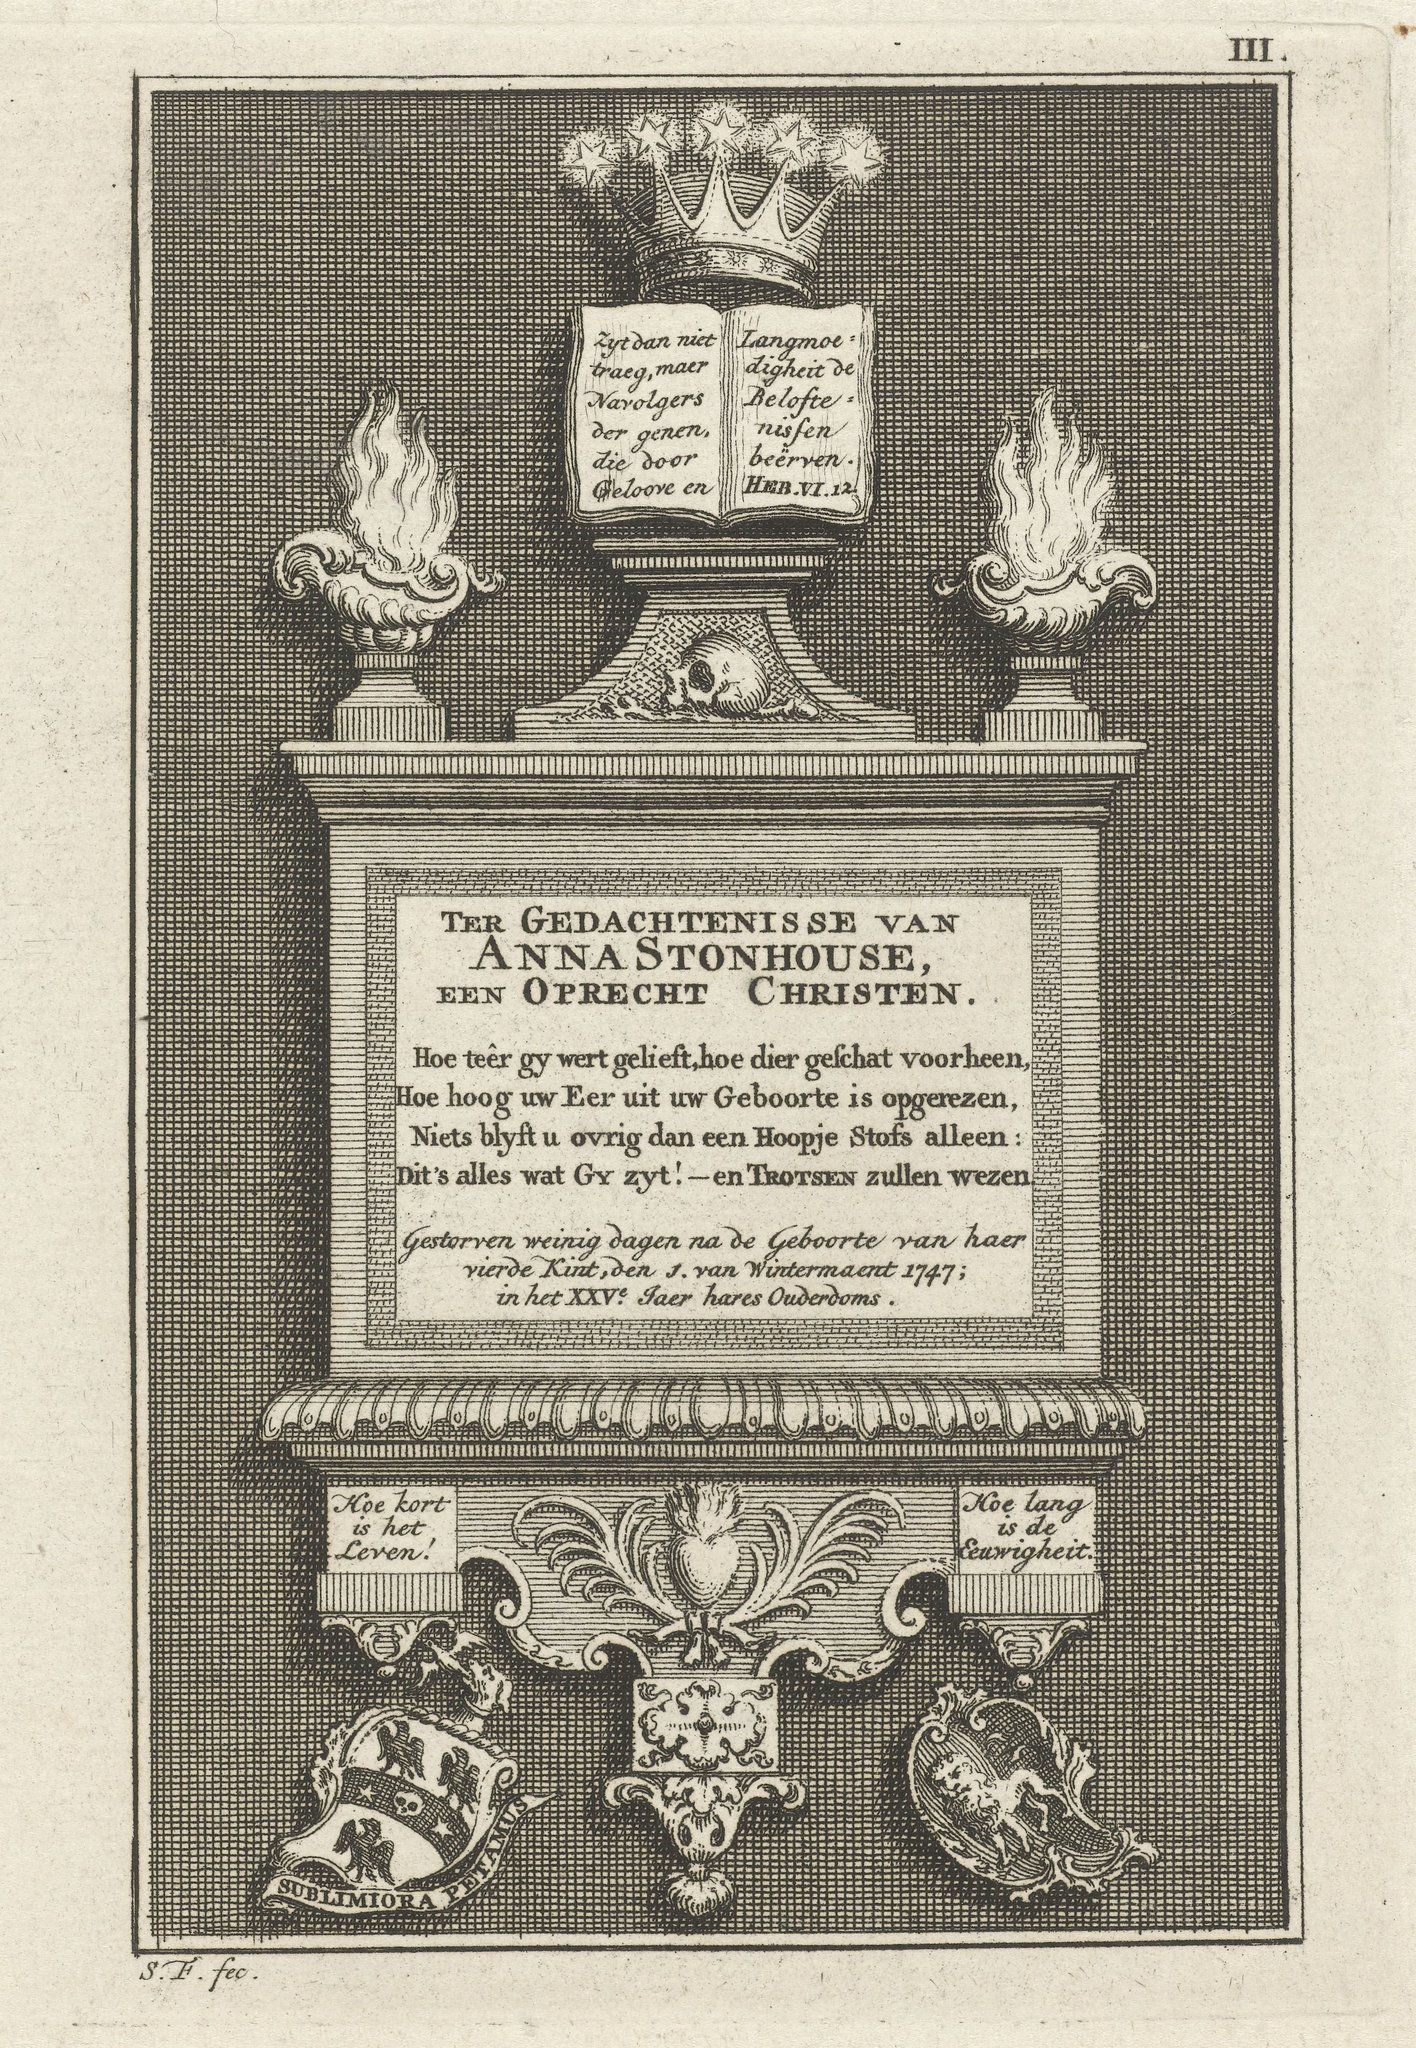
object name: print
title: Grafmonument van Anna Stonhouse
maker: simon fokke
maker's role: draughtsman, print maker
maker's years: 1712-1784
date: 1747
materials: paper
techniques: etching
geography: amsterdam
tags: grave-building, monumental tomb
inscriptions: collector's mark: Lugt 2228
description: Grafmonument van Anna Stonhouse, gekroond met een bijbelse tekst waarop een kroon met sterren is geplaatst. Onder het grafmonument staan links en rechts twee wapenschilden afgebeeld.